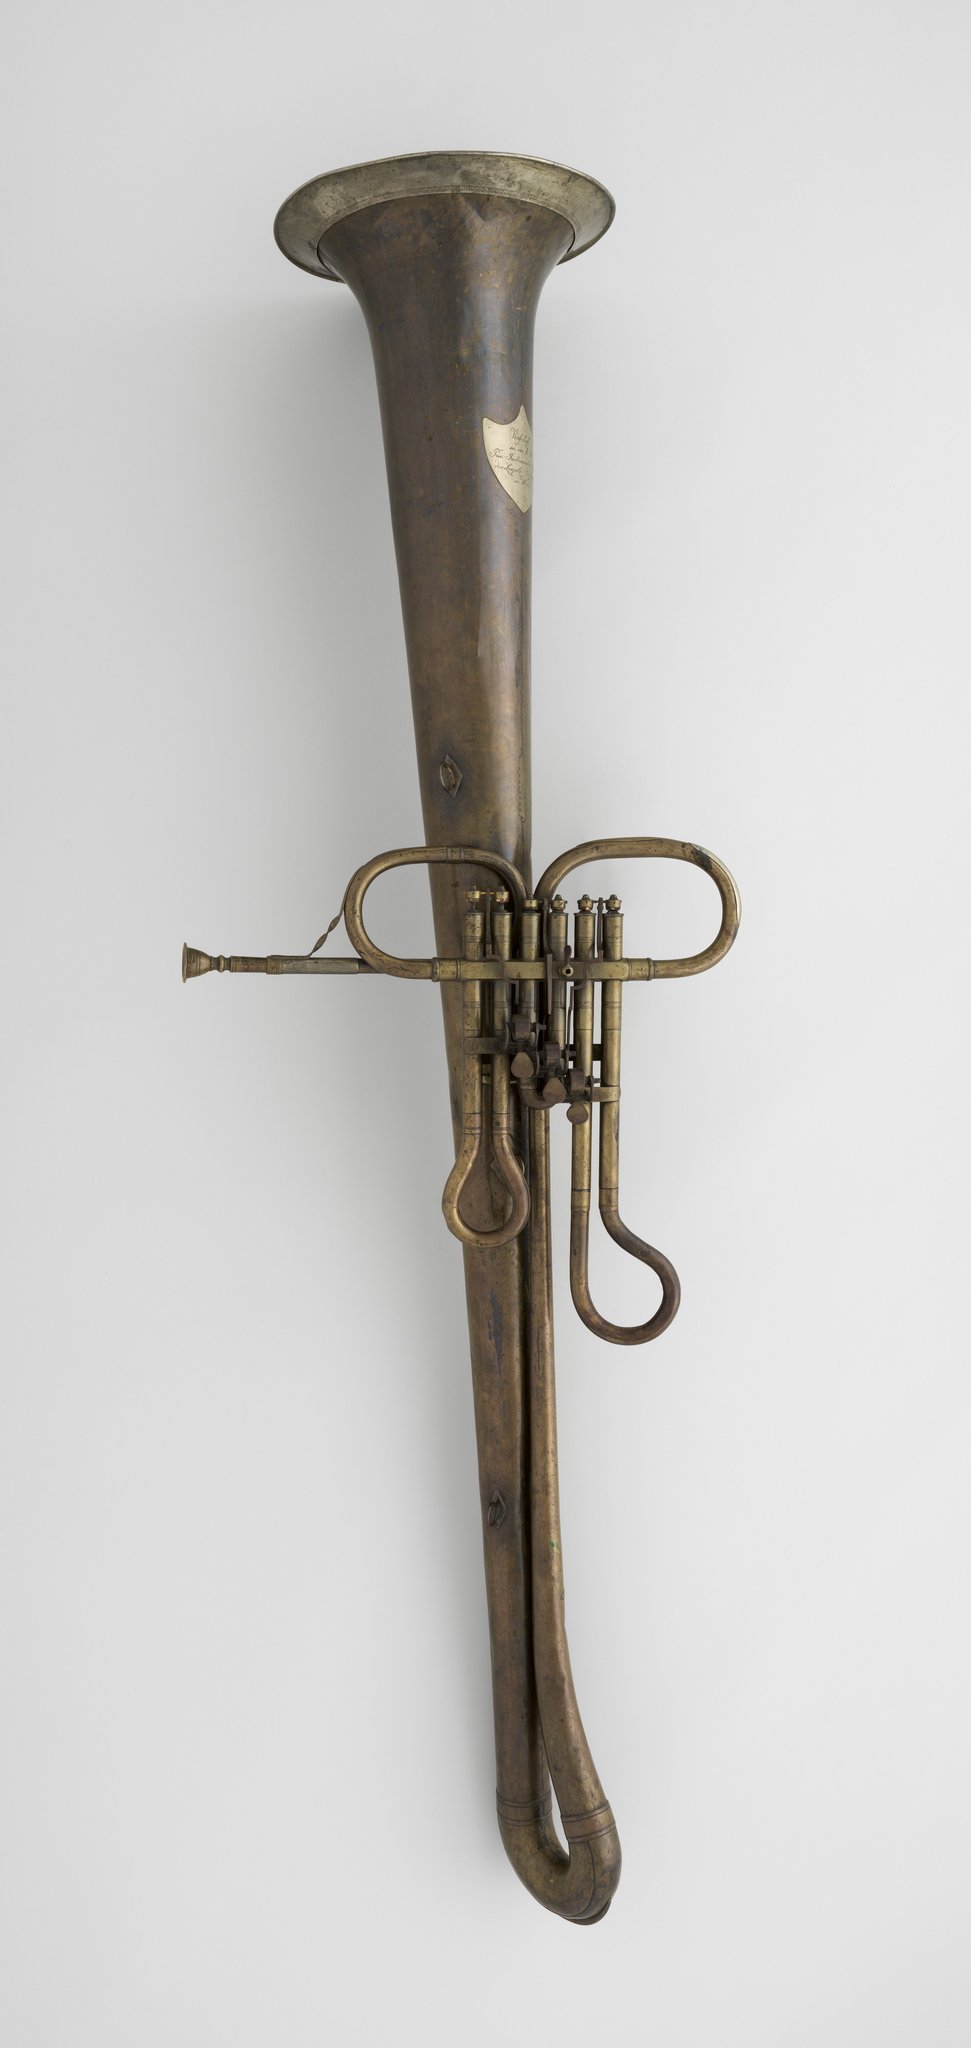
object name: contrabass valve ophicleide in d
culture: austrian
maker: leopold uhlmann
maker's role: maker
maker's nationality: austrian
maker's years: 1806-1878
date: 1840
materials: brass, nickel, silver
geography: austria